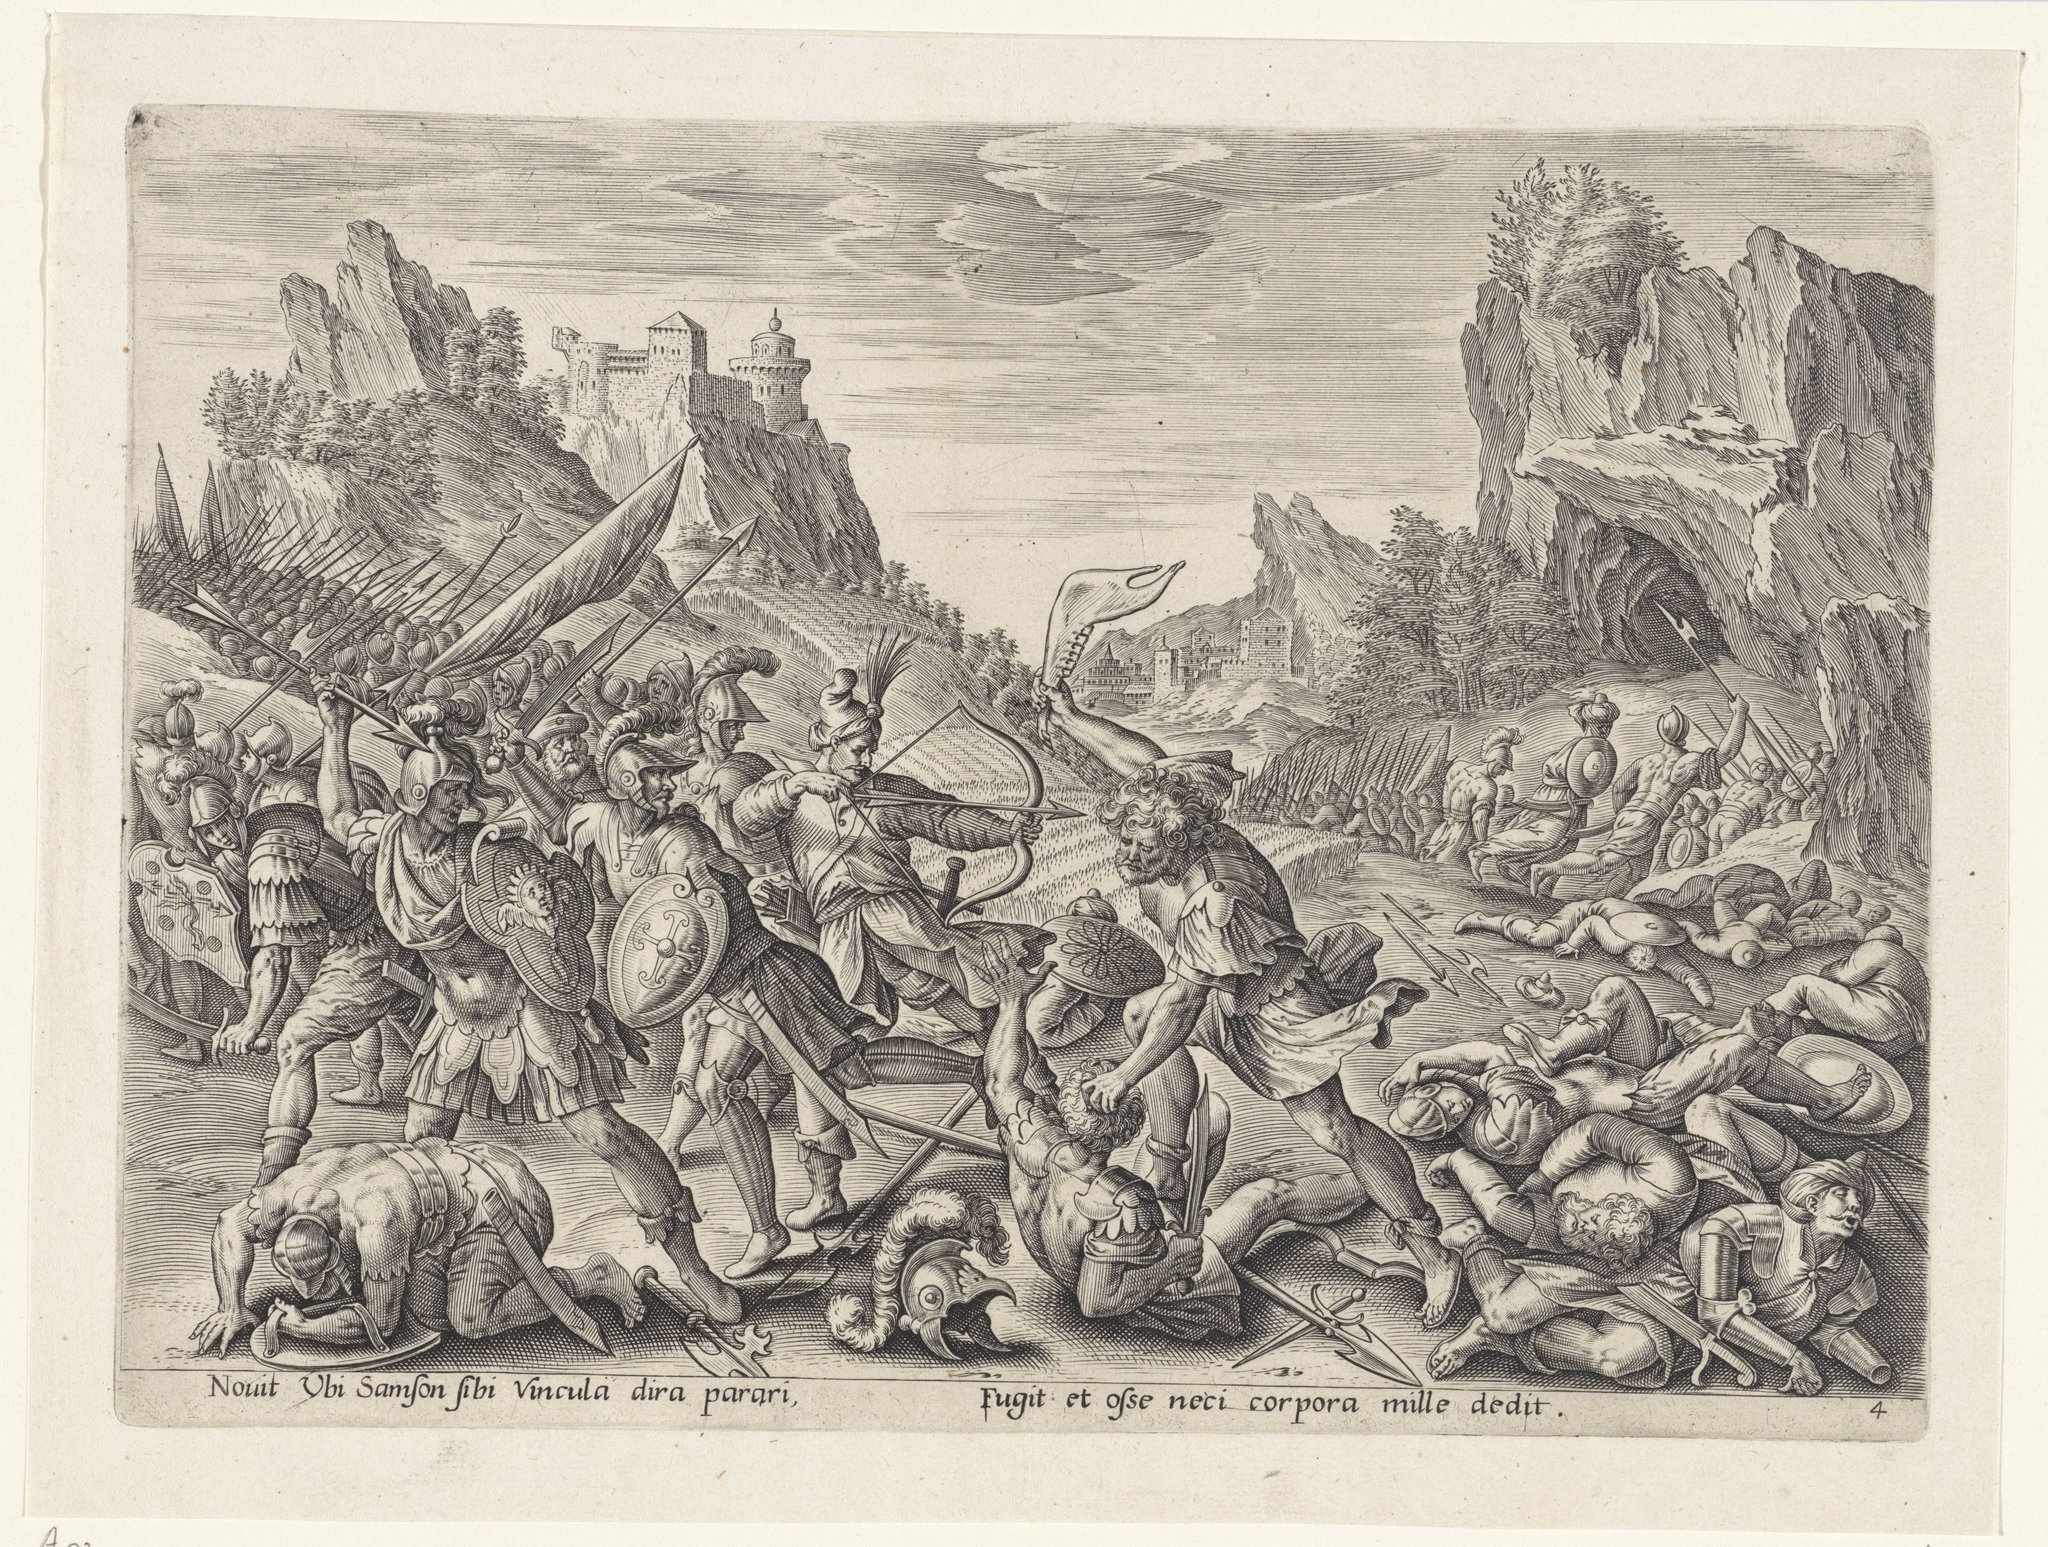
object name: print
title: Thesaurus sacrarum historiarum veteris testamenti (...)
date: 1585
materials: paper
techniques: engraving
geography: antwerp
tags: with an ass's jaw-bone samson slays a thousand philistines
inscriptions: collector's mark: Lugt 2228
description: Prent gebruikt in: Thesaurus sacrarum historiaru[m] veteris (et novi) testame[n]ti, elega[n]tissimis imaginibus expressu[m] excelle[n]tissimoru[m] in hac arte viroru[m] opera : nu[n]c primu[m] in luce[m] editus. Antwerpen: Gerard de Jode, 1585.